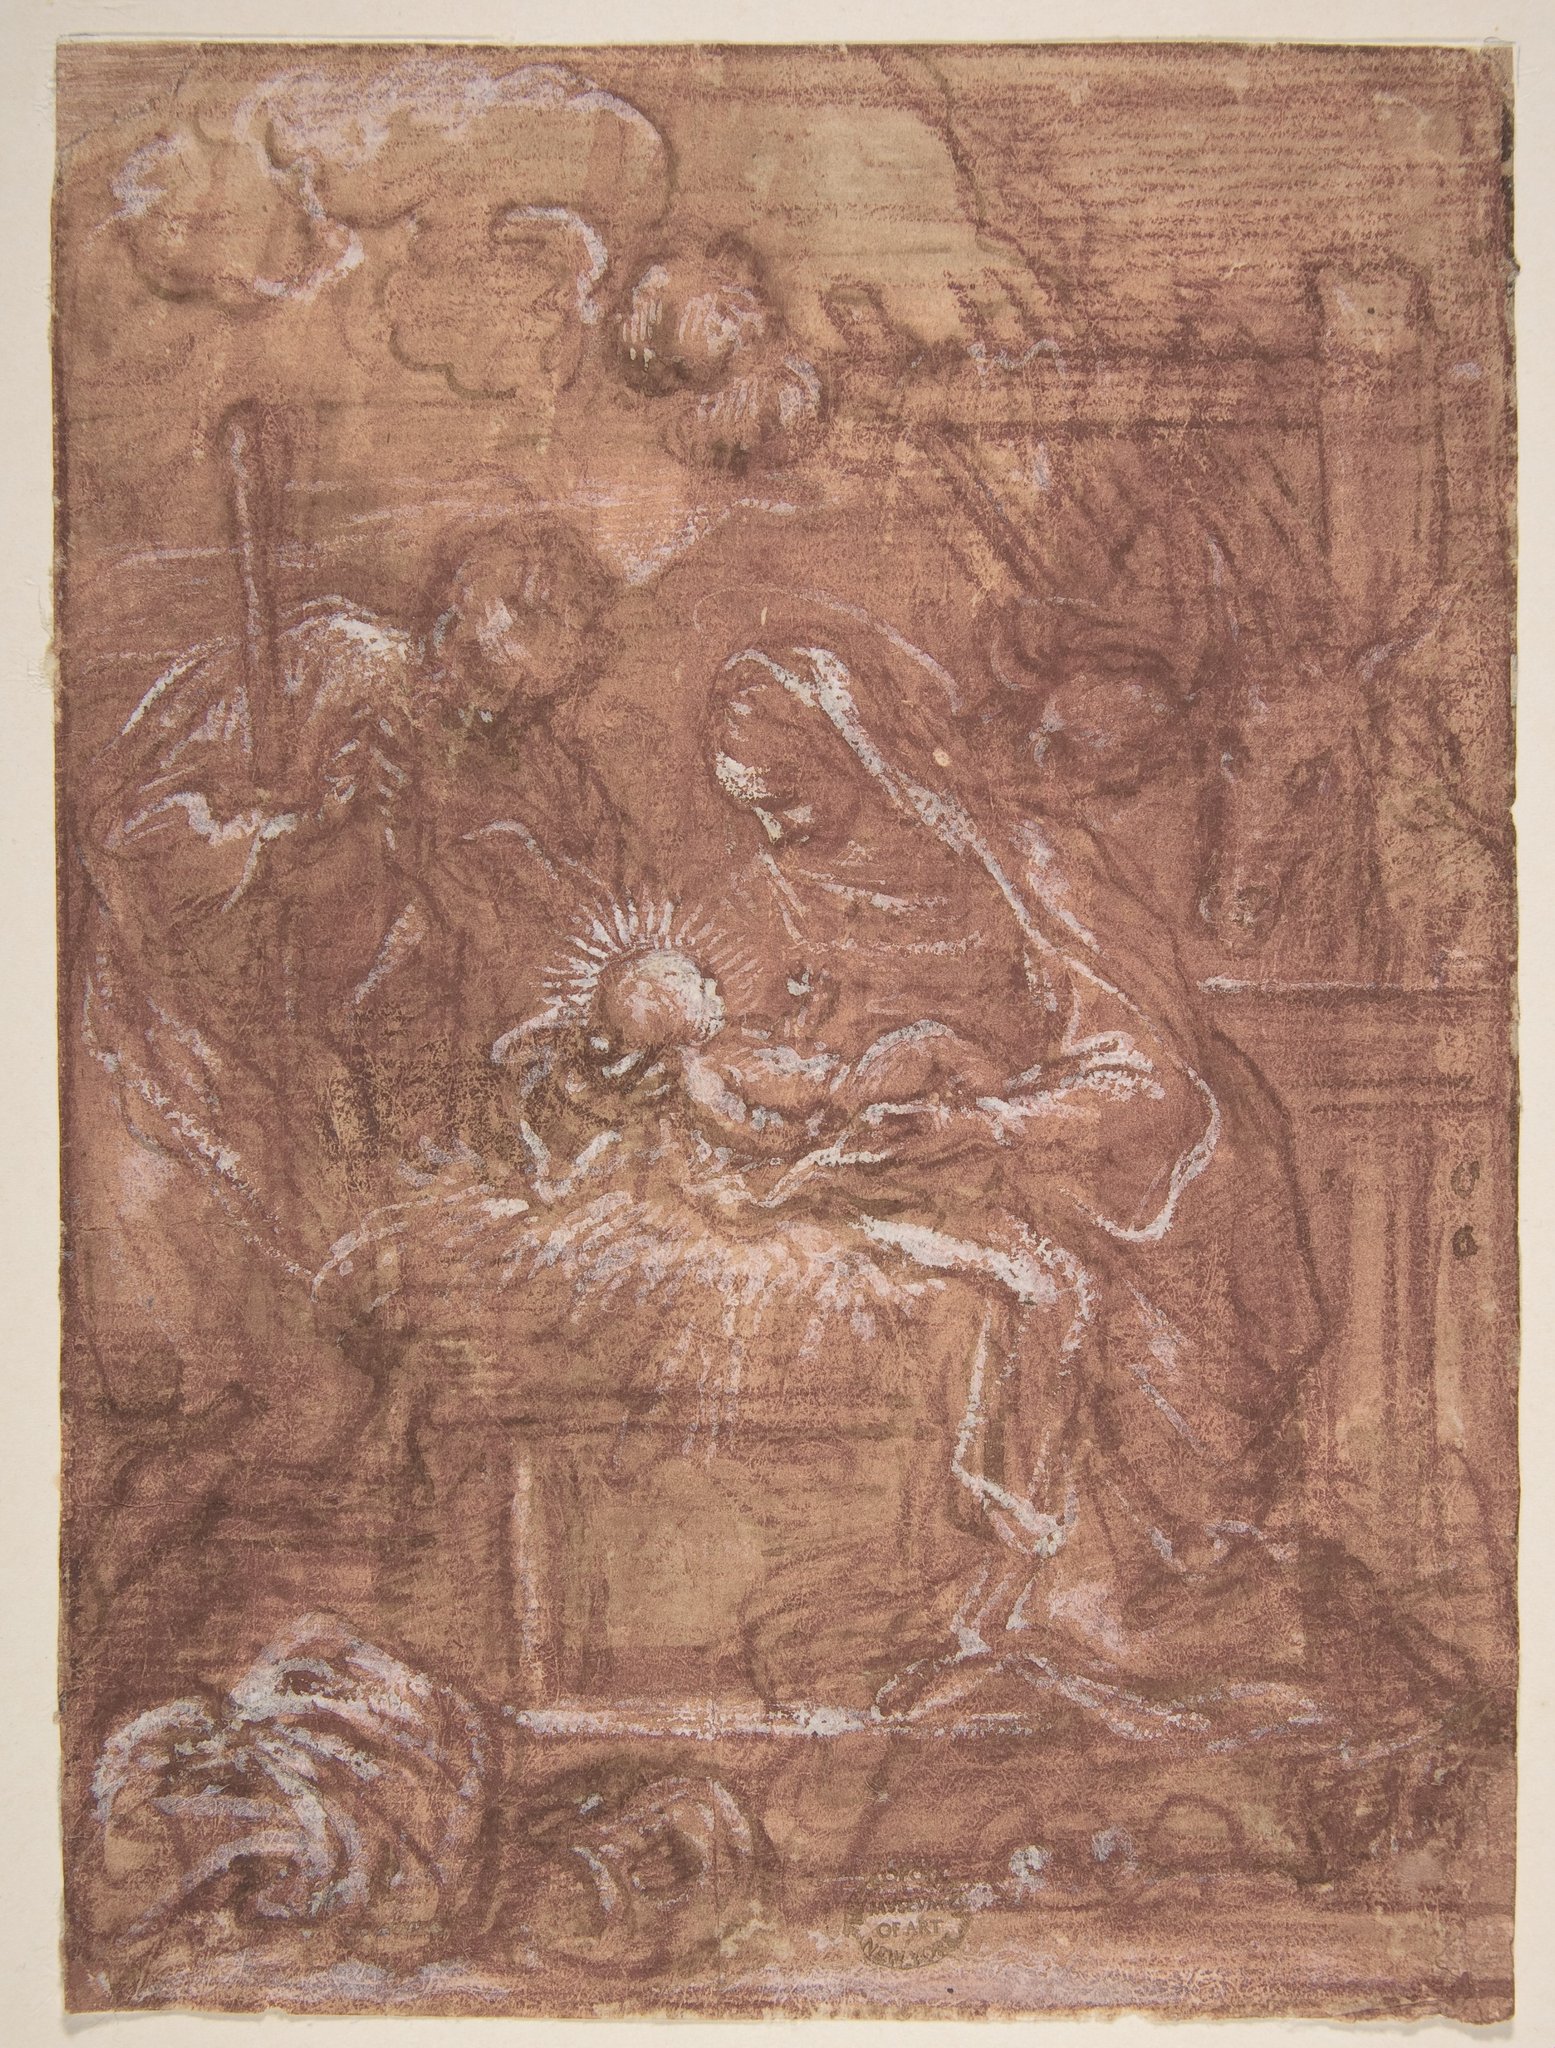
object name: drawing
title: The Nativity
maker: giuseppe passeri (passari)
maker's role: artist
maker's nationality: italian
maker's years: 1654-1714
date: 1654-1714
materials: chalk, ink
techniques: brush, highlighting, pen, wash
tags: madonna and child,nativity